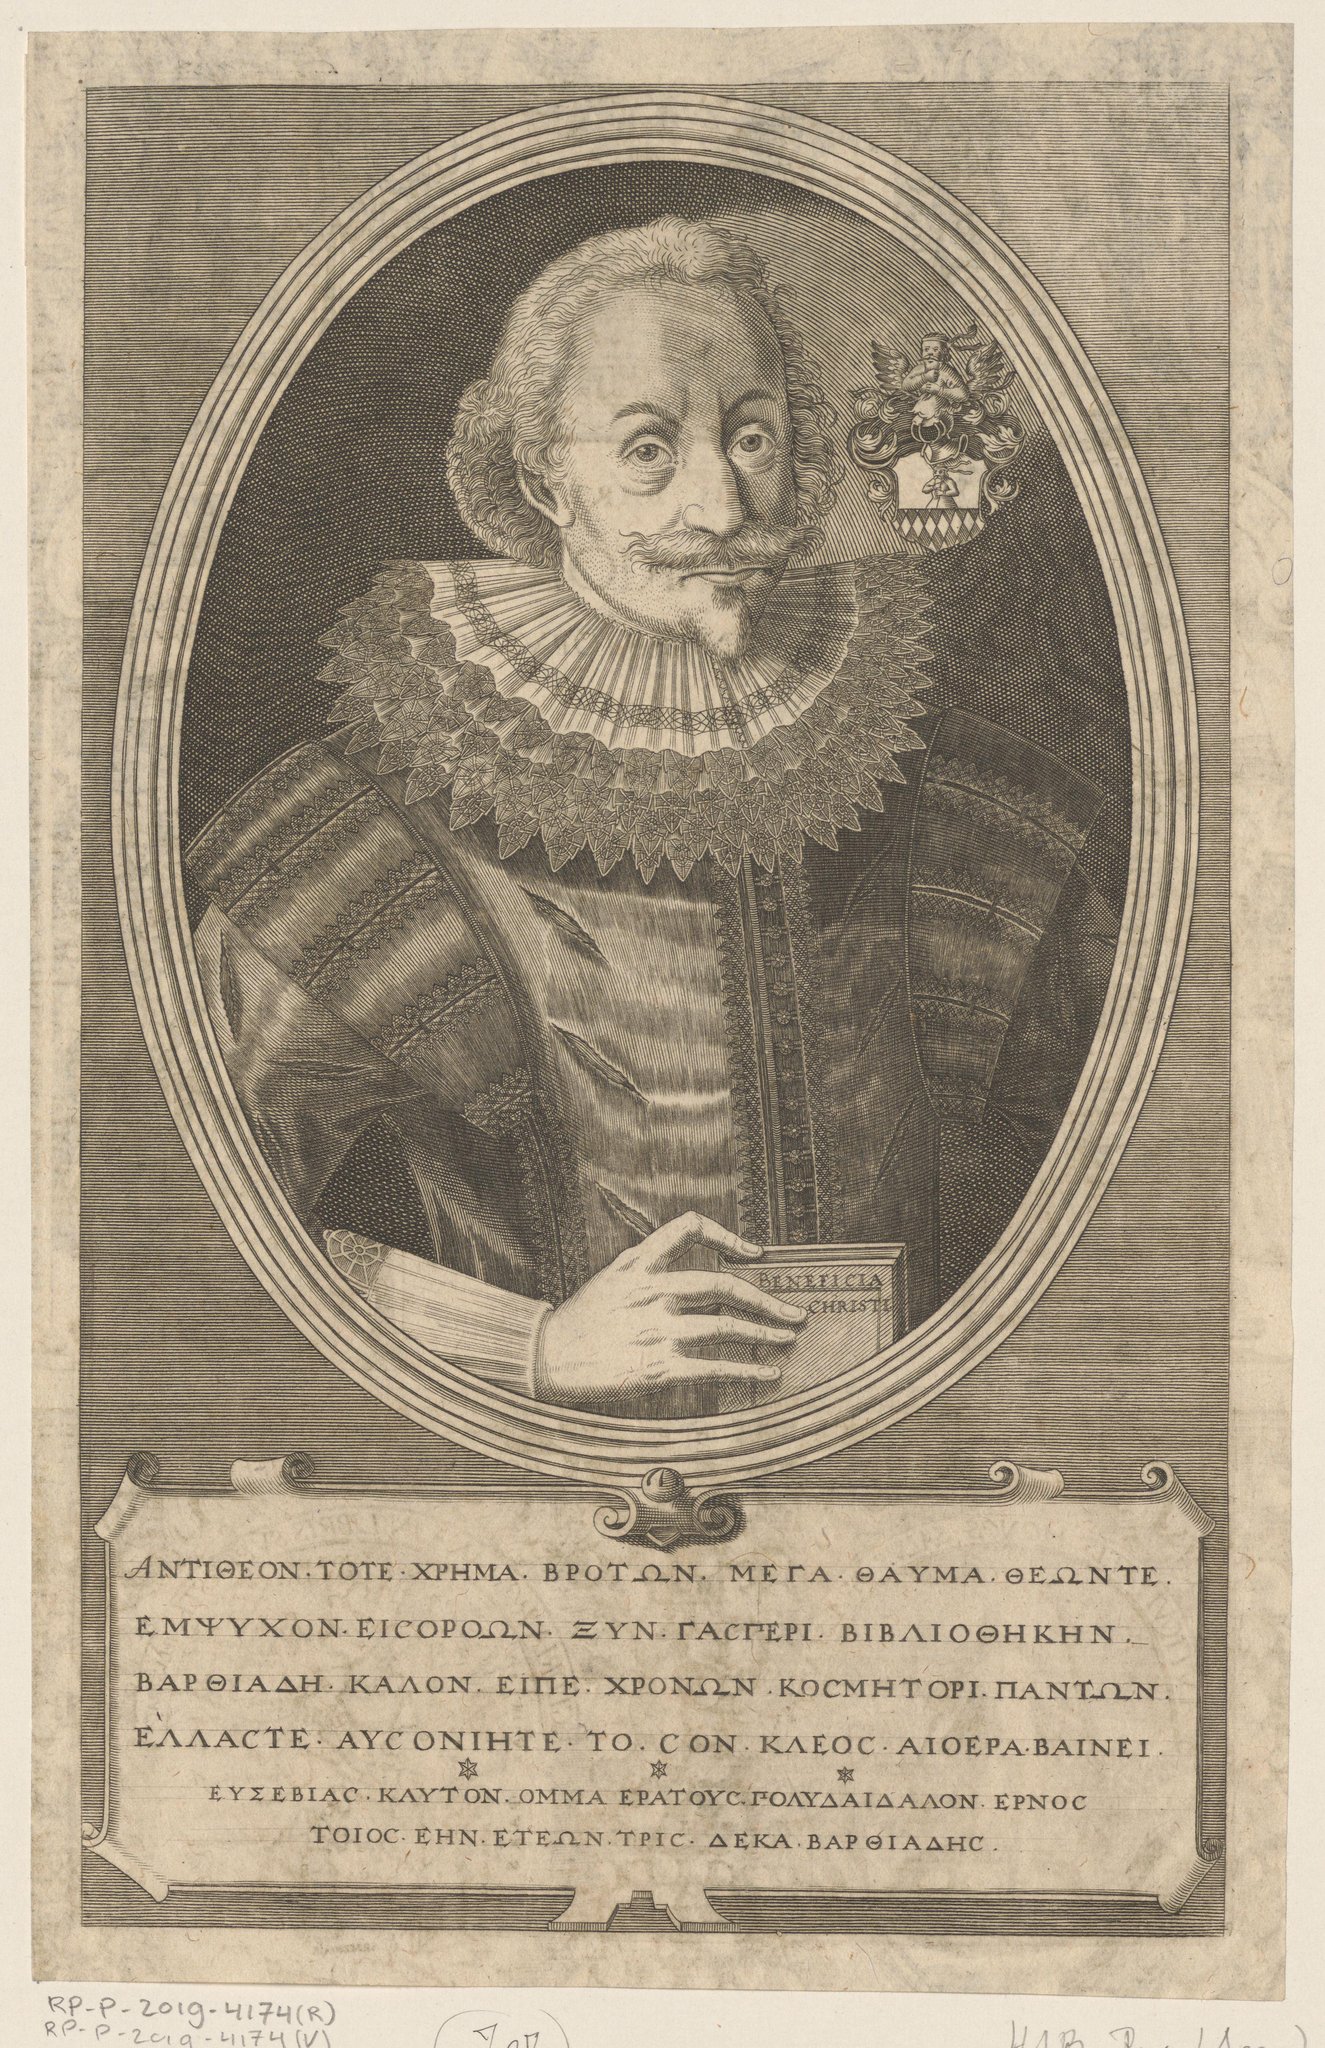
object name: print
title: Portret van Caspar von Barth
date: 1624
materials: paper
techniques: engraving, etching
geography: frankfurt am main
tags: caspar von barth, historical persons, book, armorial bearing, heraldry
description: Prent uit: Barth, Caspar von. Adversariorum commentariorum libri LX. Frankfurt am Main: erven Andreas Wechel, Daniël en David Aubry en Clemens Schleich, 1624. Prent ook gebruikt in de 1648-editie, uitgegeven door Johann Press te Frankfurt am Main.